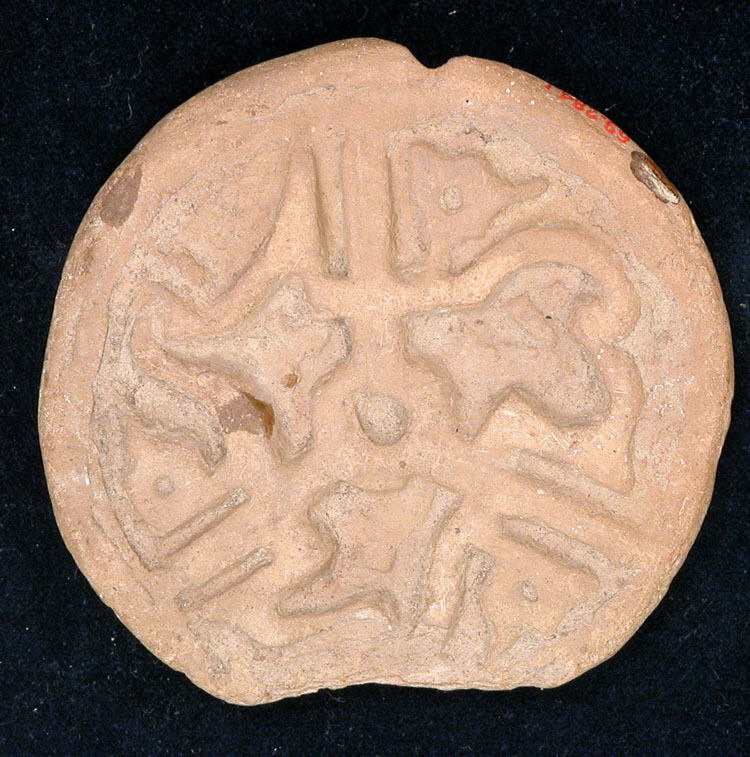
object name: bath scraper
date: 1101-1300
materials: earthenware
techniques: molding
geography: iran